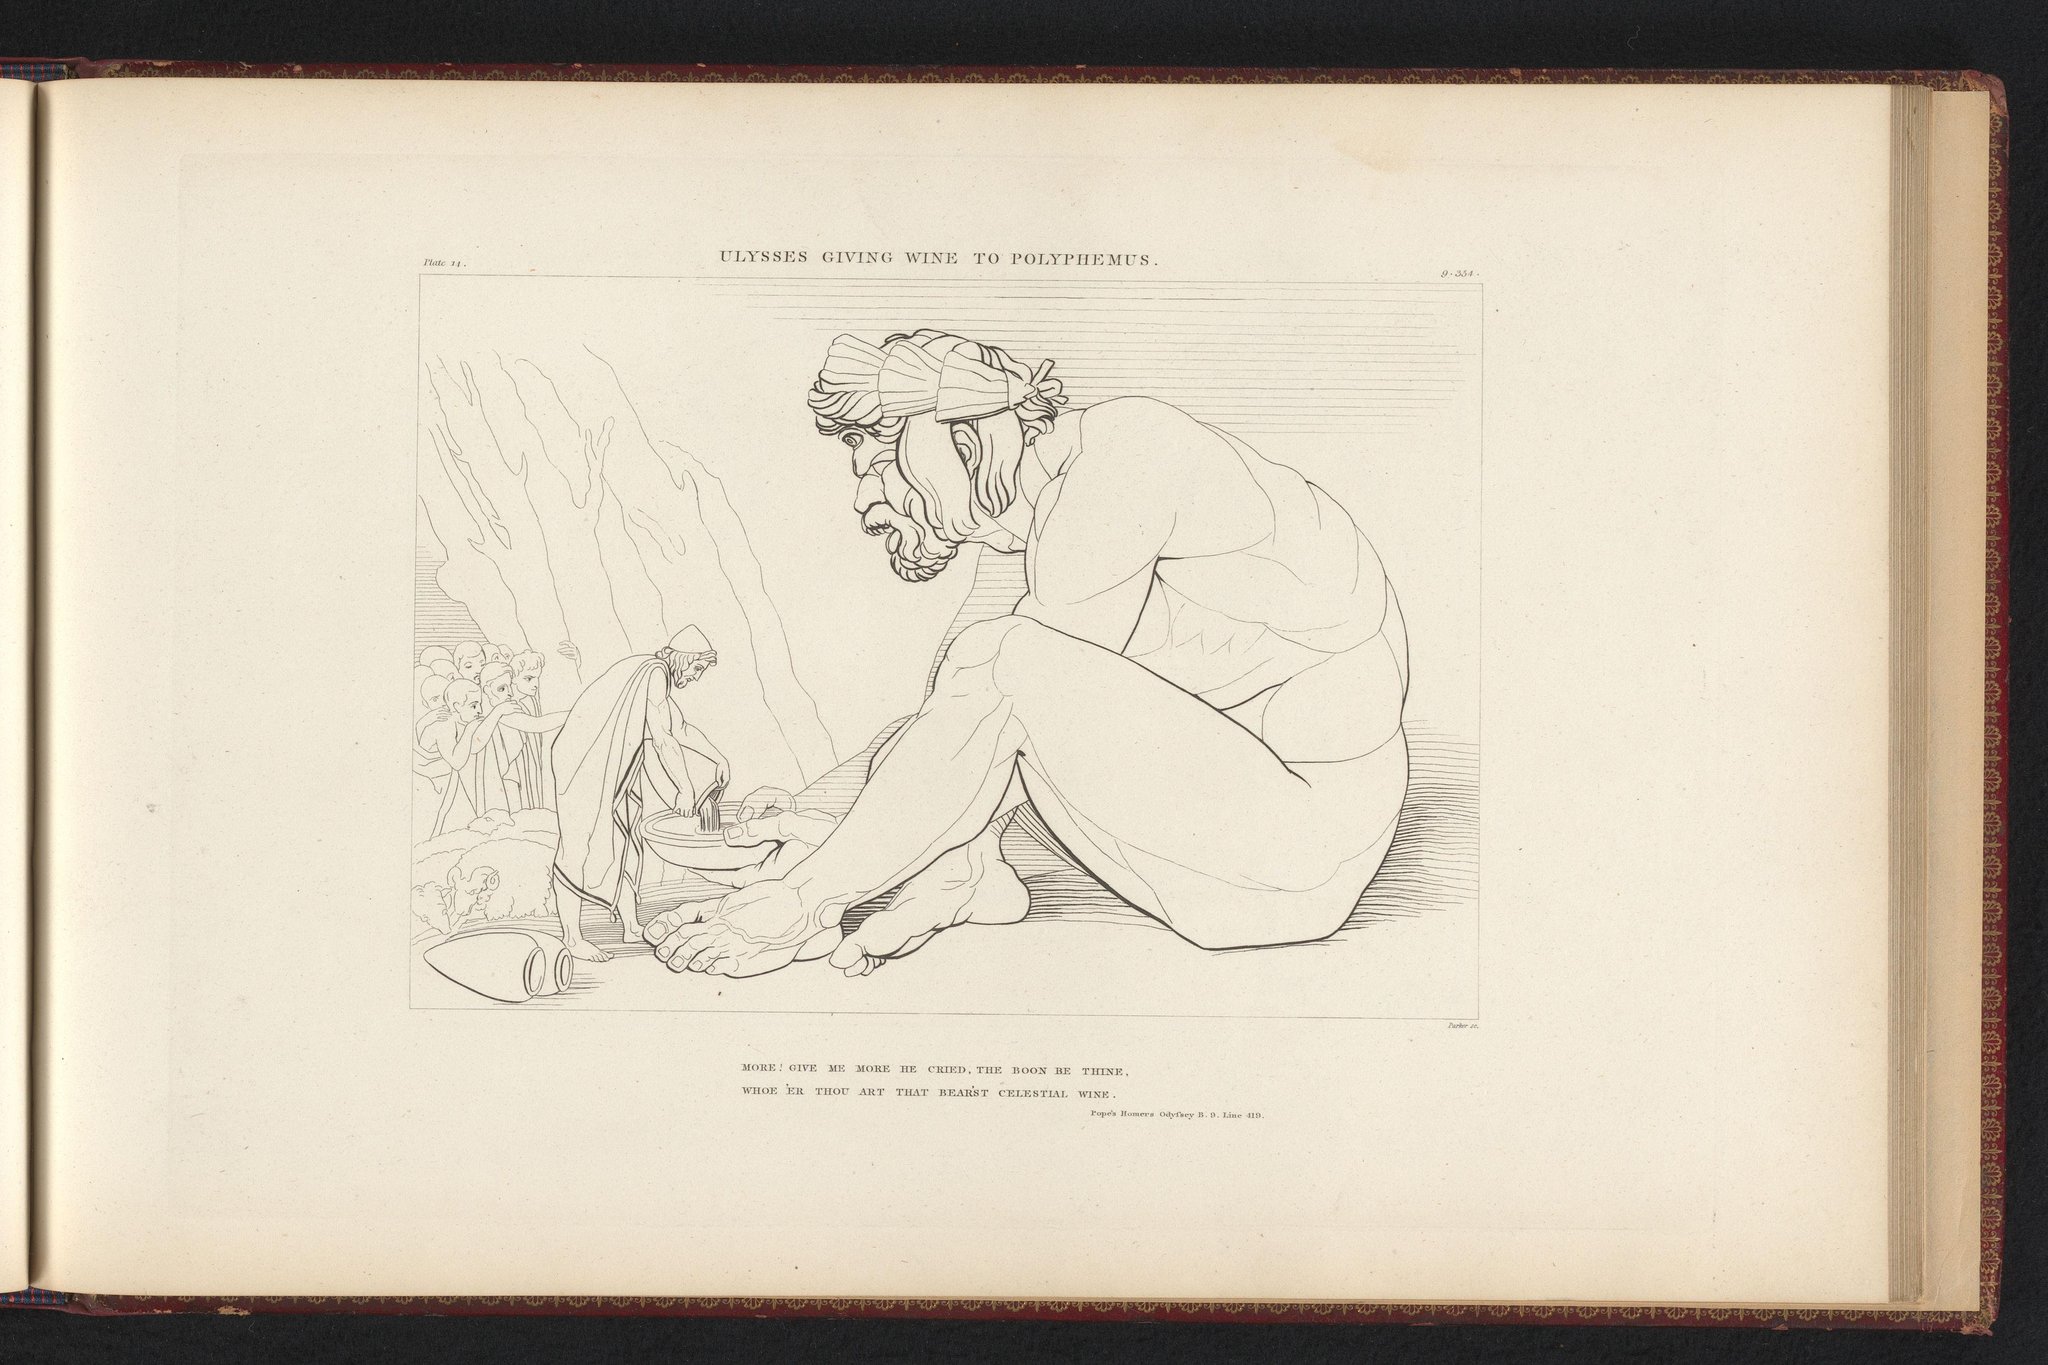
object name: print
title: Ulysses giving wine to Polyphemus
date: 1805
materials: paper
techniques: etching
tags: ulysses offers wine to polyphemus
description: Prent maakt onderdeel uit van een serie met 34 prenten over de Odyssee, geschreven door Homerus.